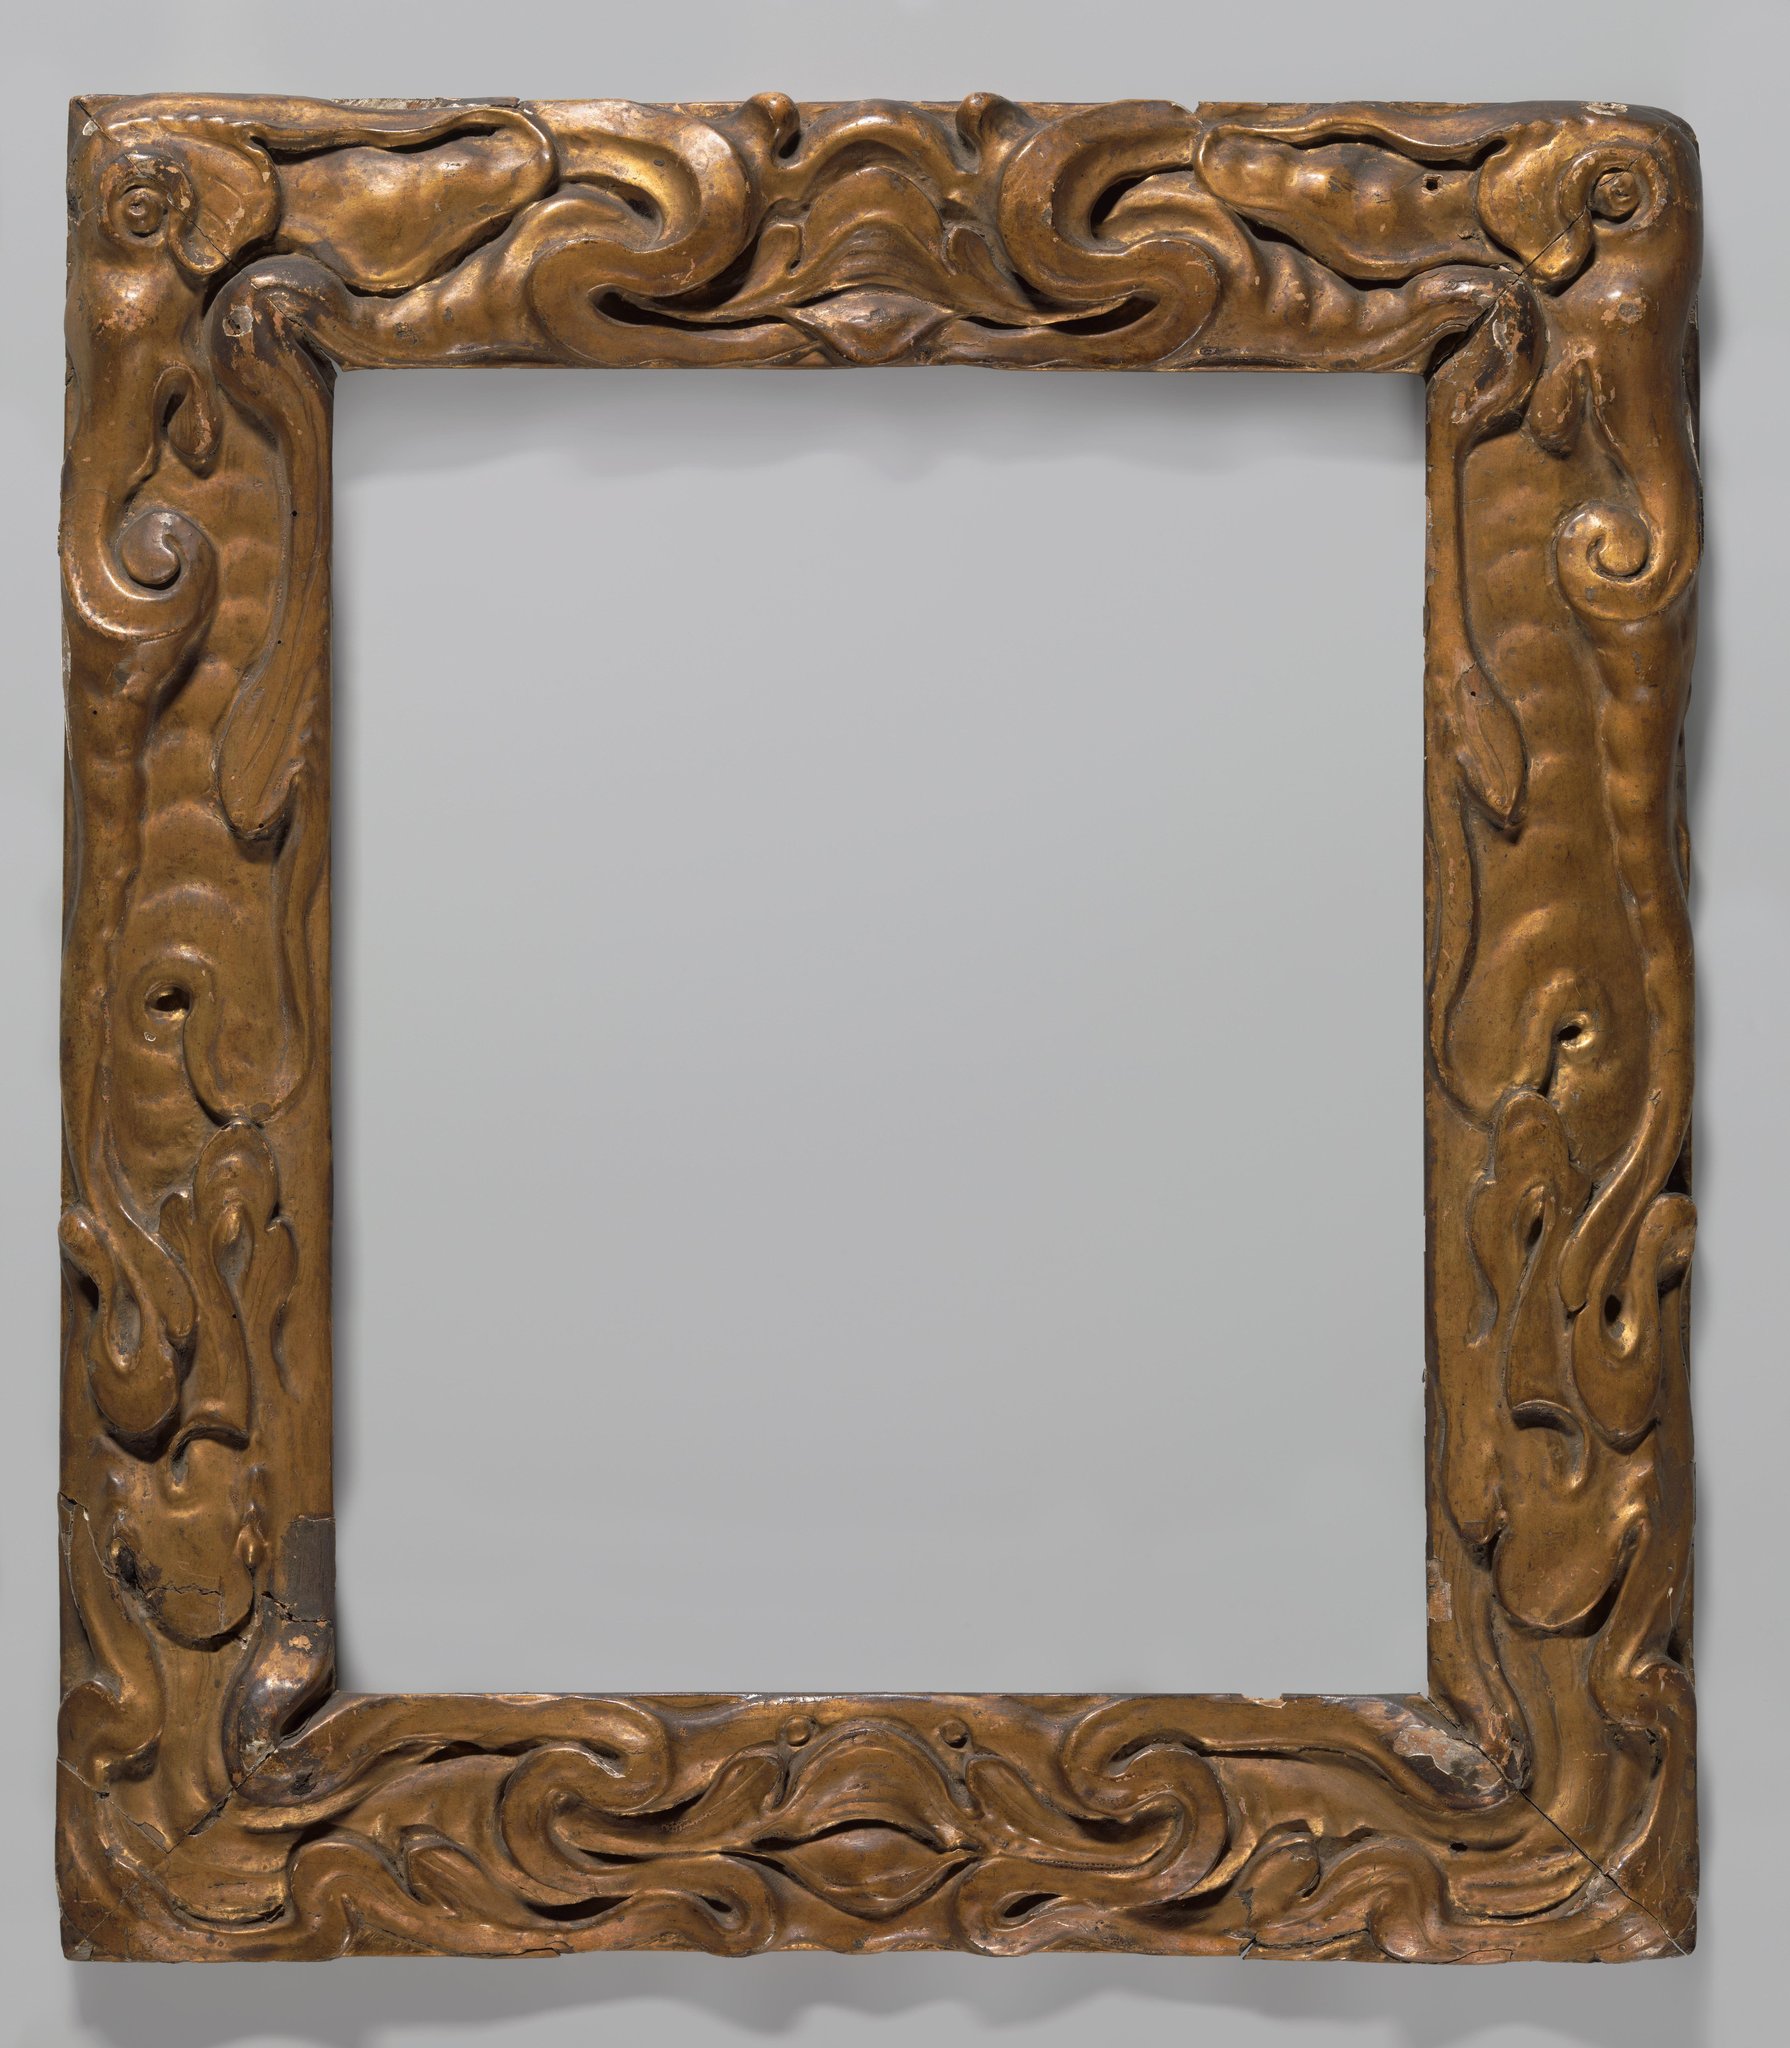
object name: frame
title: Picture Frame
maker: Anonymous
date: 1650-1660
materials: wood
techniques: cutting, gilding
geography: netherlands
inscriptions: inscription: ‘L’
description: This is a smaller version of the frames of the Schade portraits shown nearby. Picture frames of a particular pattern could be produced in considerable numbers. This frame is also one of a pair. They were preserved separately from their paintings.